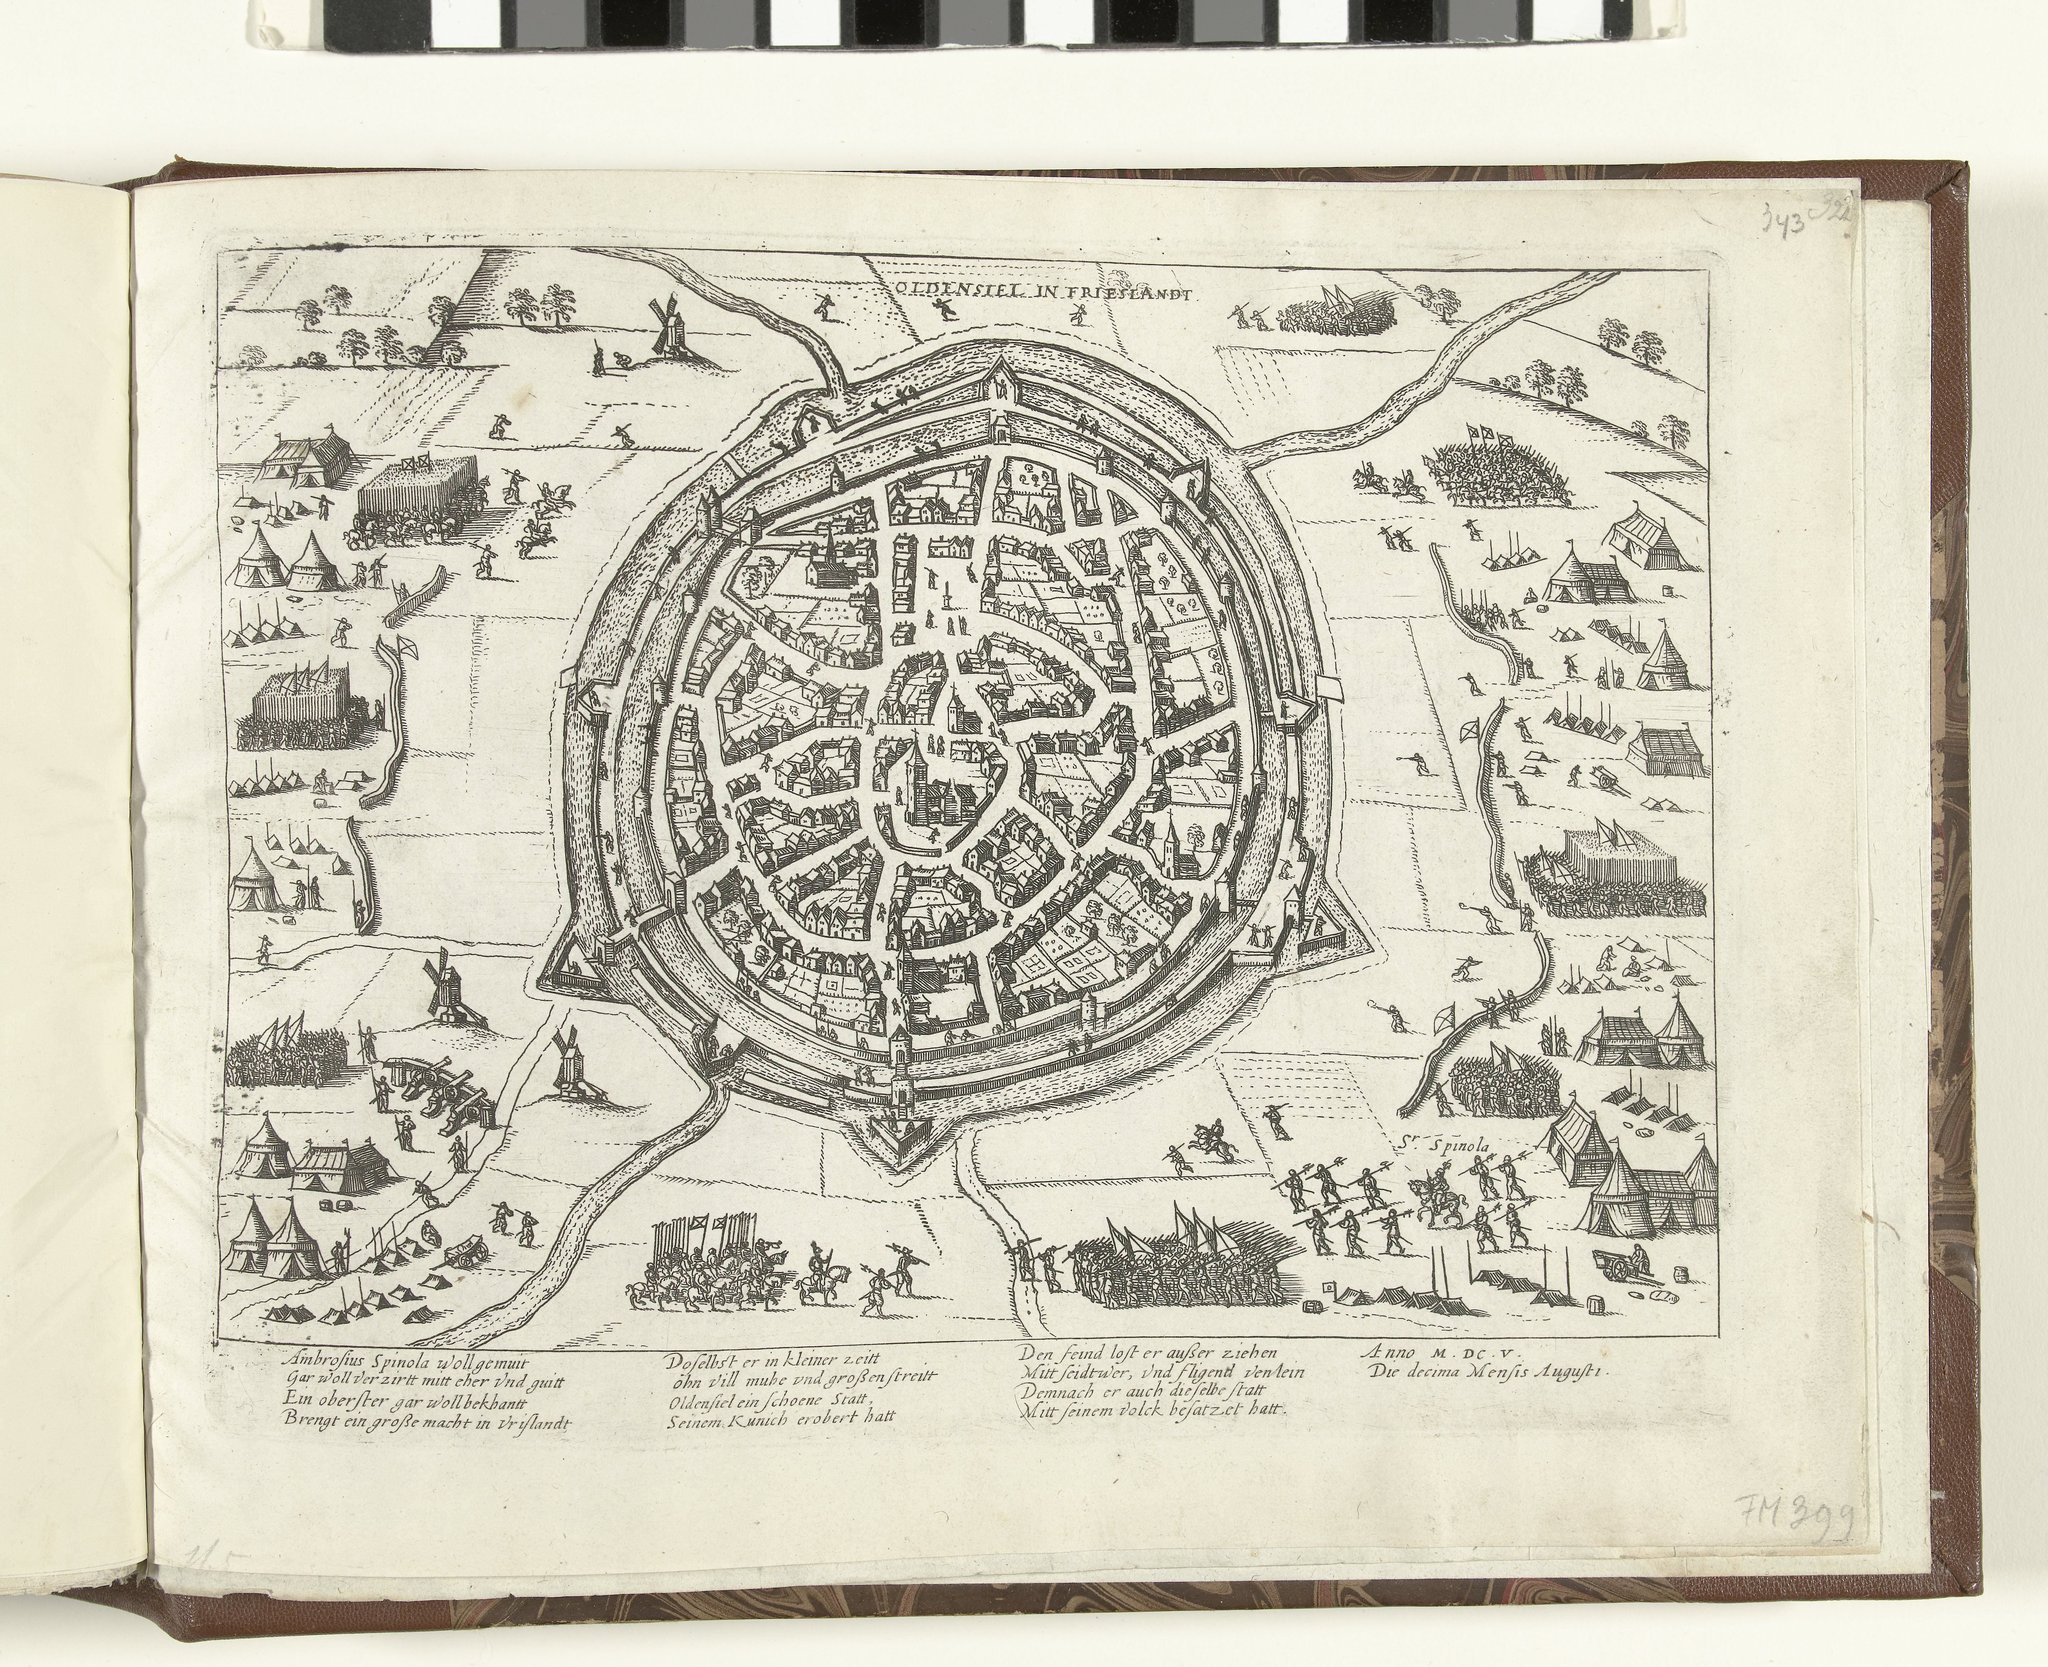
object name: print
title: Serie 11: Varia Buitenlandse Gebeurtenissen, 1571-1631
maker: frans hogenberg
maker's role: print maker, publisher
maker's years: 1538-1590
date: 1605-1607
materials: paper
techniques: etching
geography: cologne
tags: capture of city (after the siege)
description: Inname van Oldenzaal door Spinola, 10 augustus 1605. Gezicht op de stad en de omsingeling door het leger van Spinola. Met onderschrift van 12 regels in het Duits. Ongenummerd.